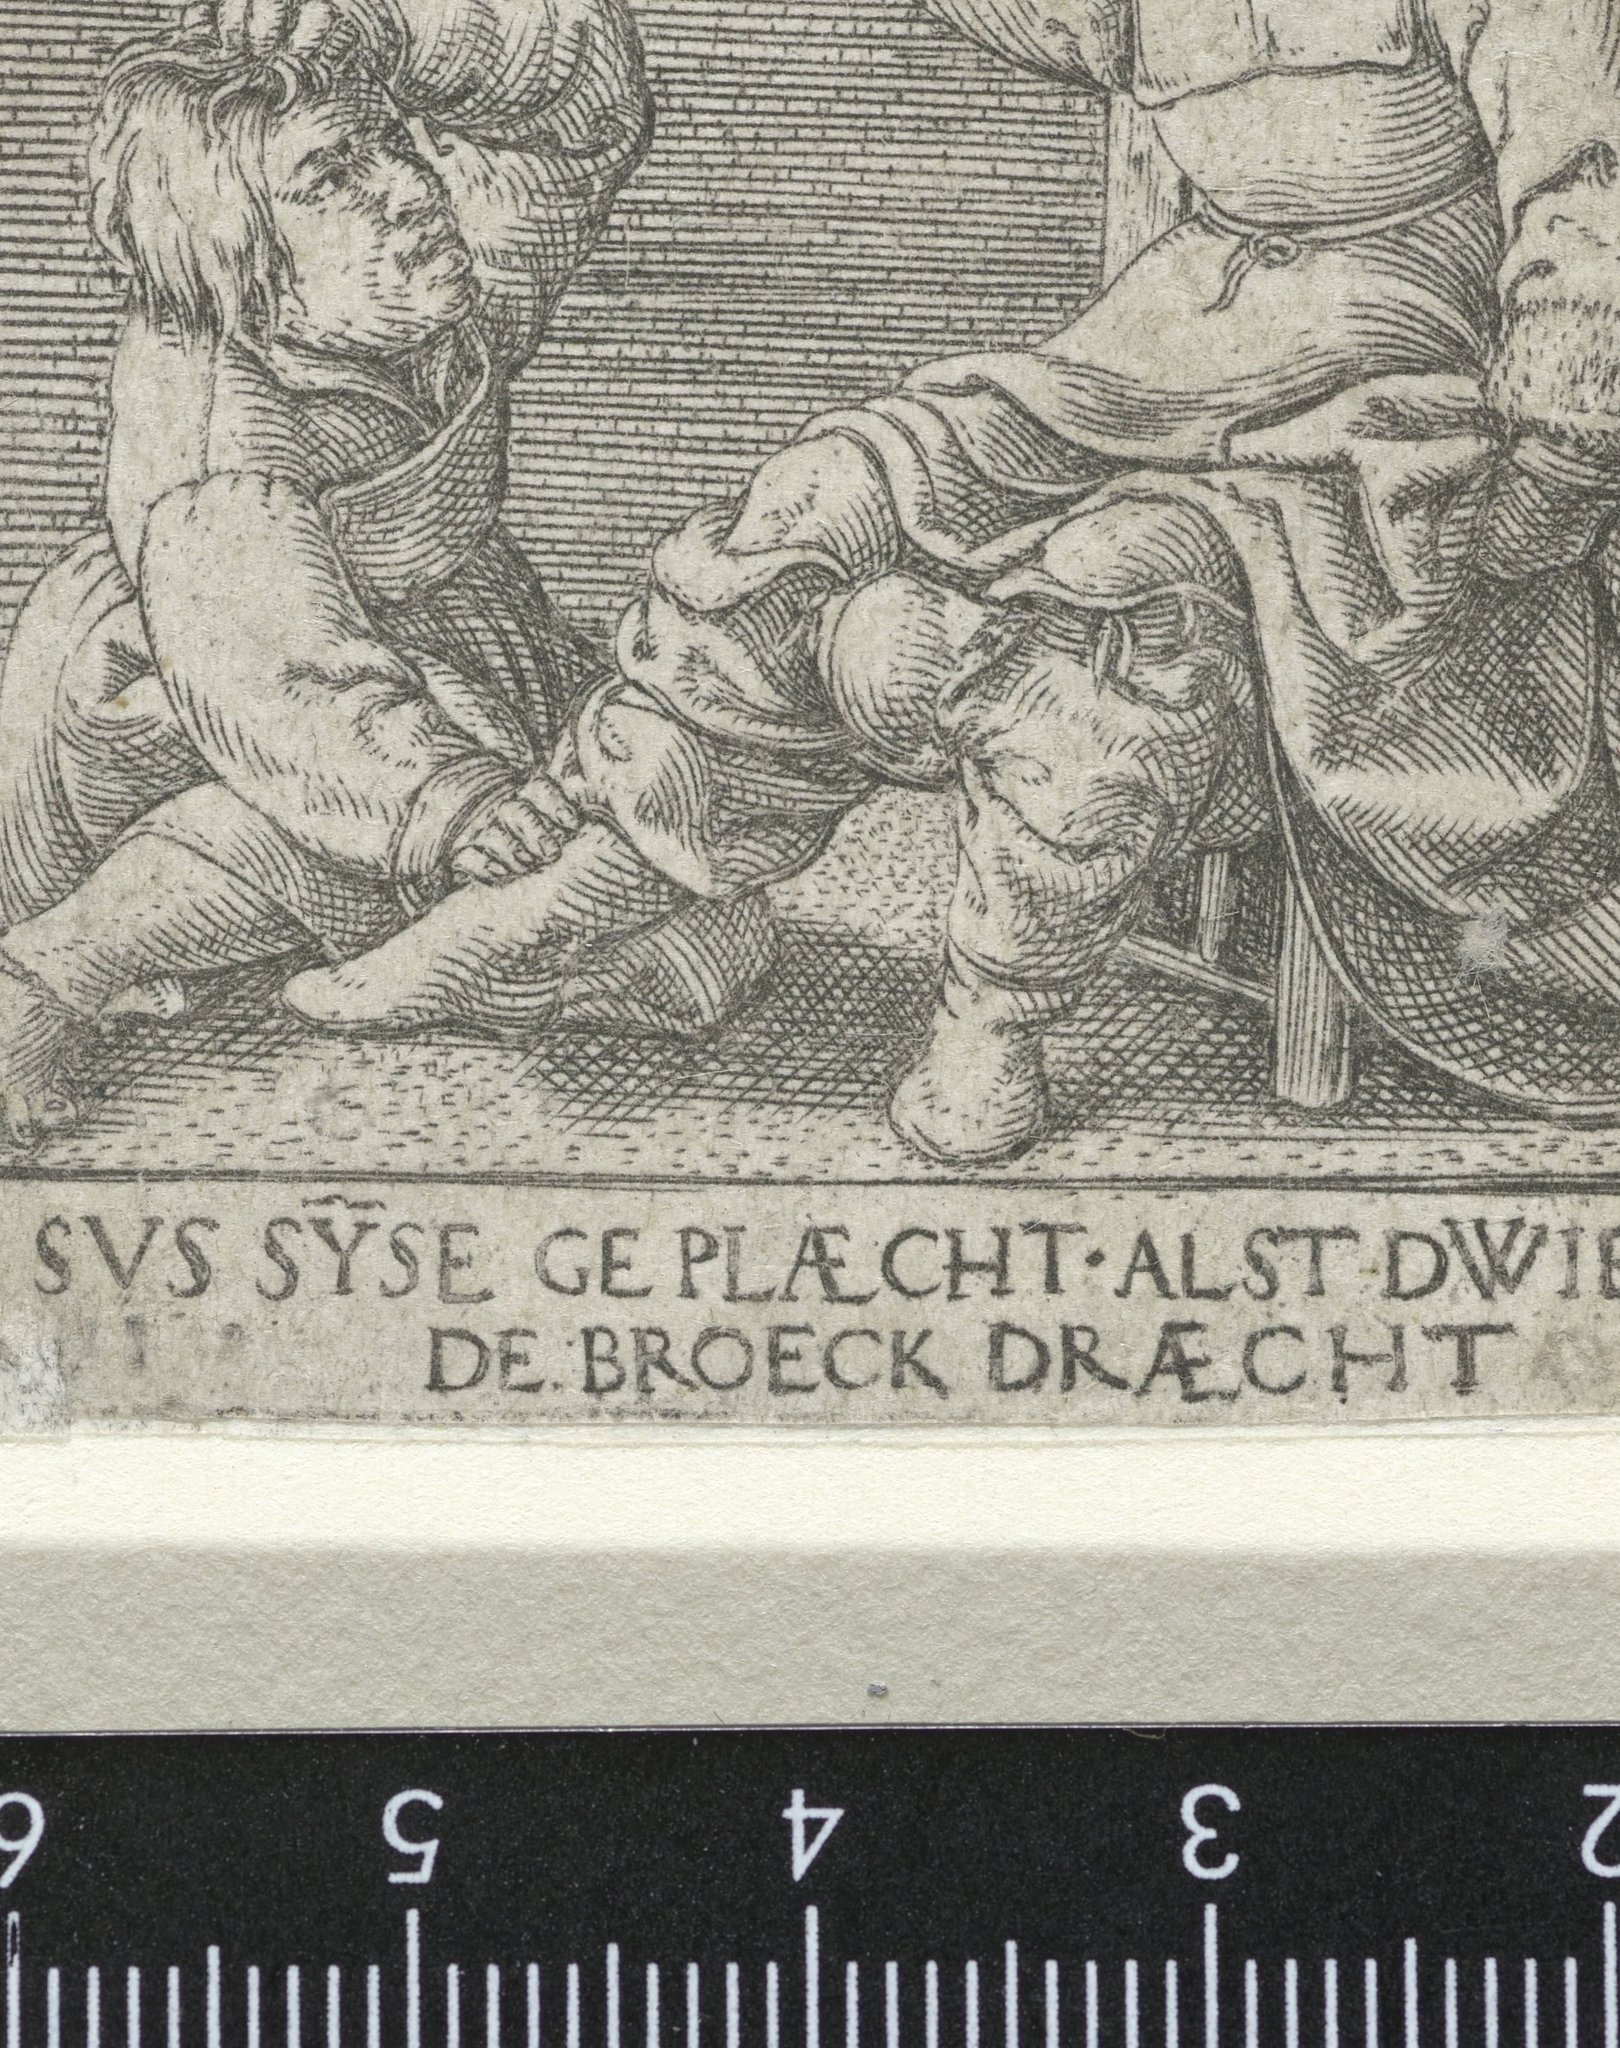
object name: print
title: Strijd om de broek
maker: cornelis massijs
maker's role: painter, print maker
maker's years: 1510-1557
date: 1539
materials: paper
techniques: engraving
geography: antwerp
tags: battle for dominance in marriage ('who wears the breeches')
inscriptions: collector's mark: Lugt 2228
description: Een vrouw zit op een stoel en probeert de broek van haar man aan te trekken. Haar man zit op de grond en probeert de broek uit te trekken, terwijl hij zijn andere hand in wanhoop naar zijn hoofd brengt. Op de achtergrond een venster en een plank met borden en een kan erop.